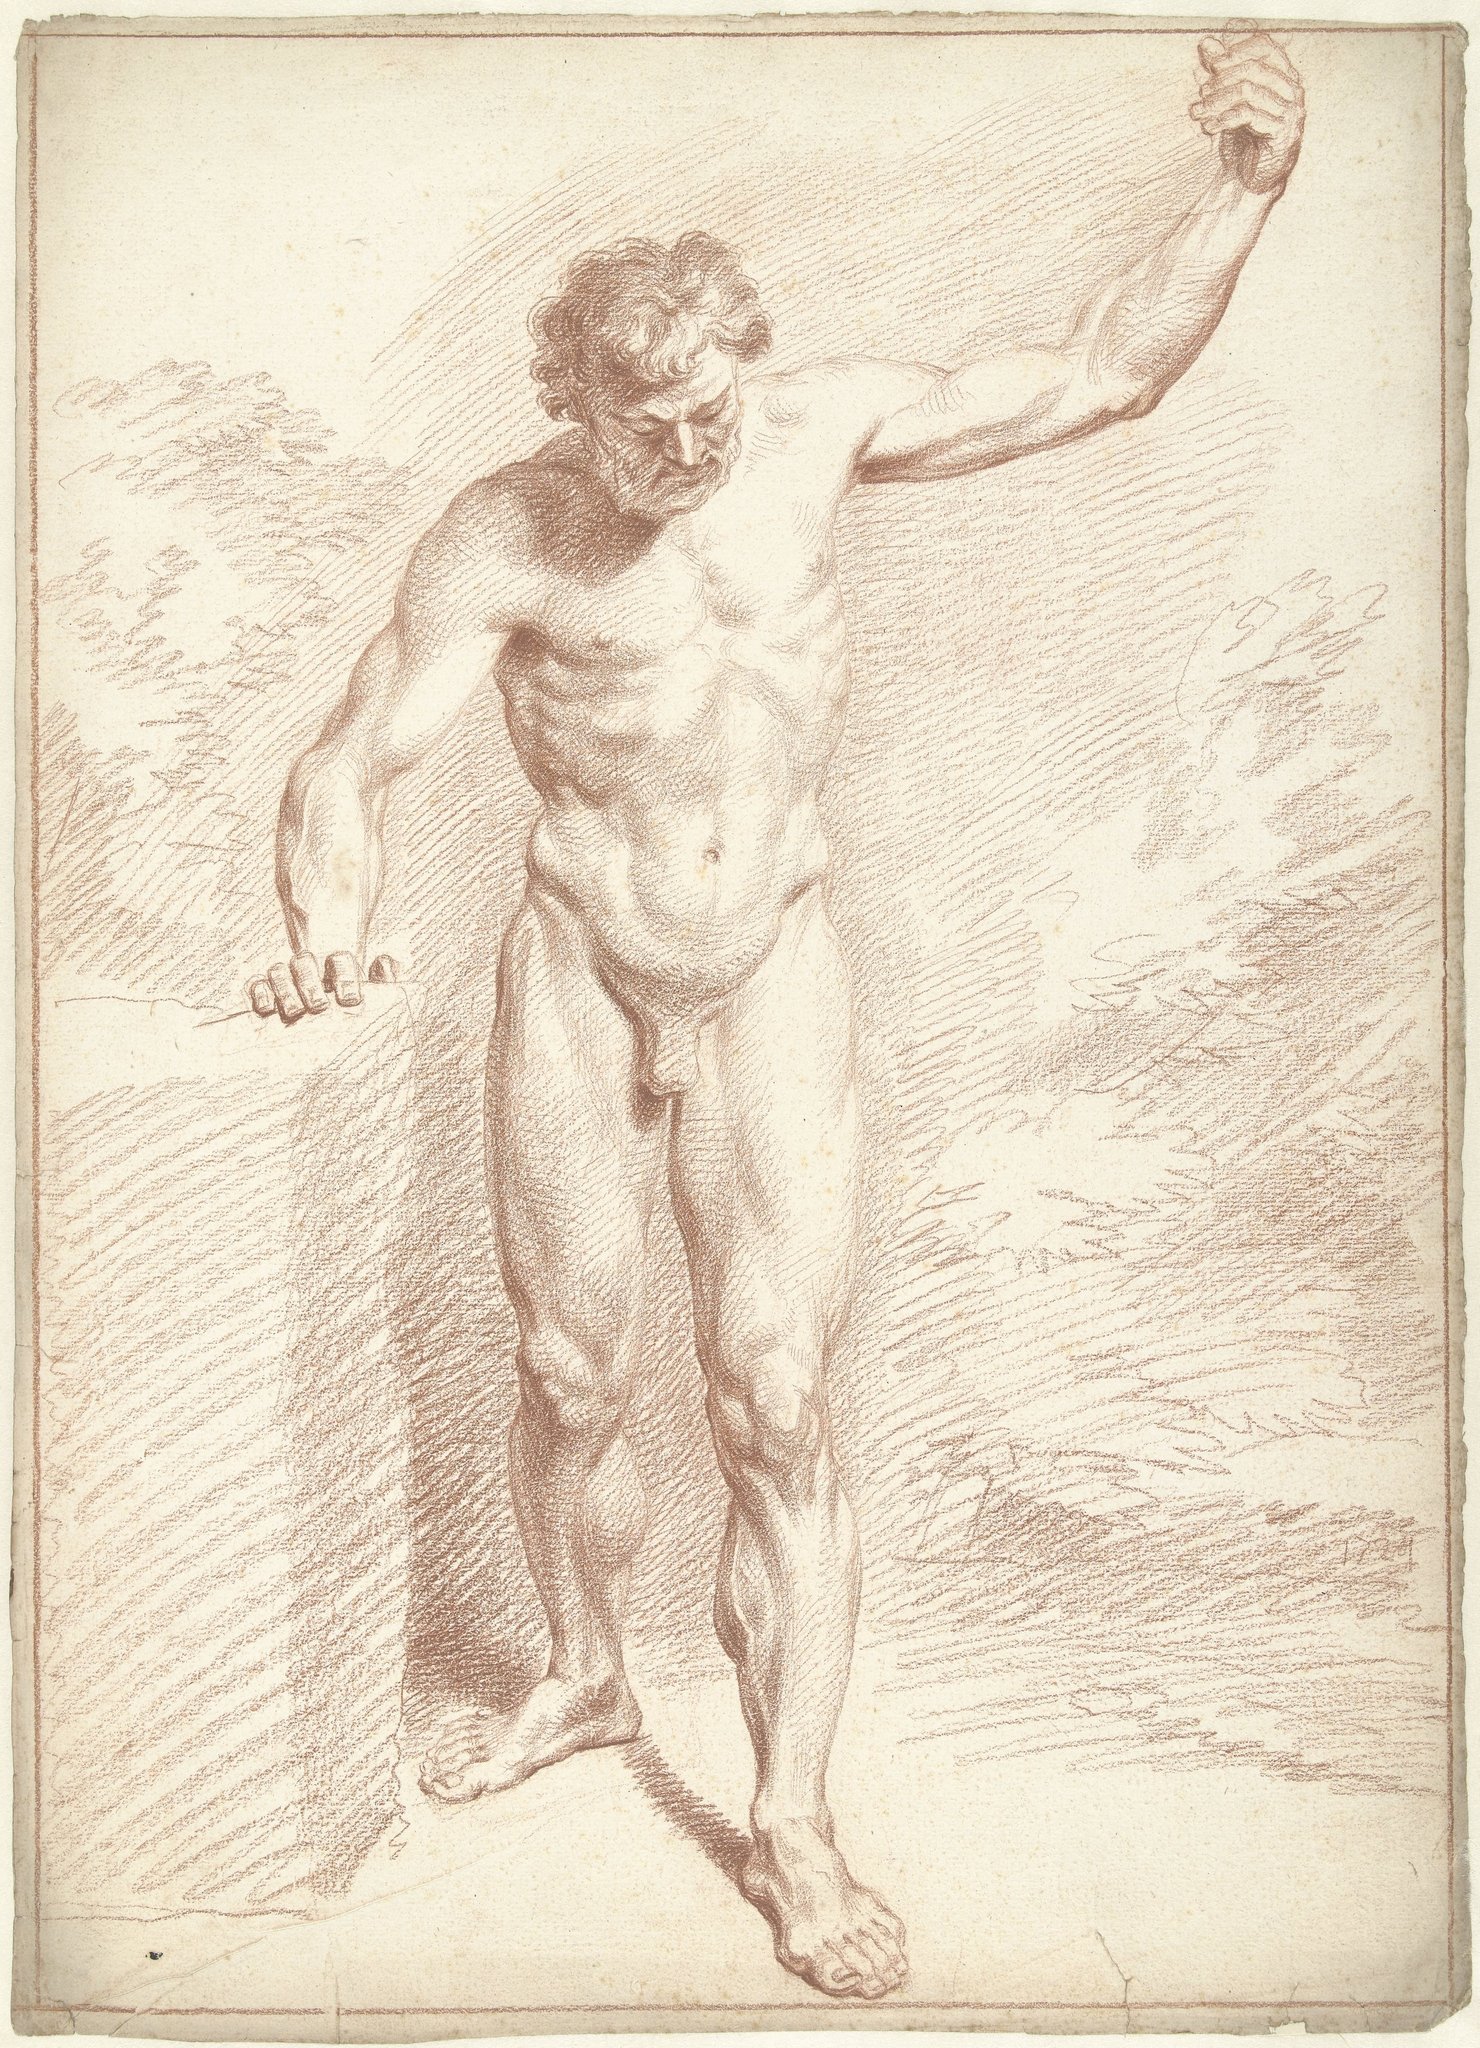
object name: drawing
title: Mannelijk naakt, staand, de linkerarm geheven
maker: louis fabritius dubourg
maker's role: draughtsman, print maker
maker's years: 1693-1775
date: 1724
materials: chalk, paper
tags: the (nude) human figure; 'corpo humano' (ripa)